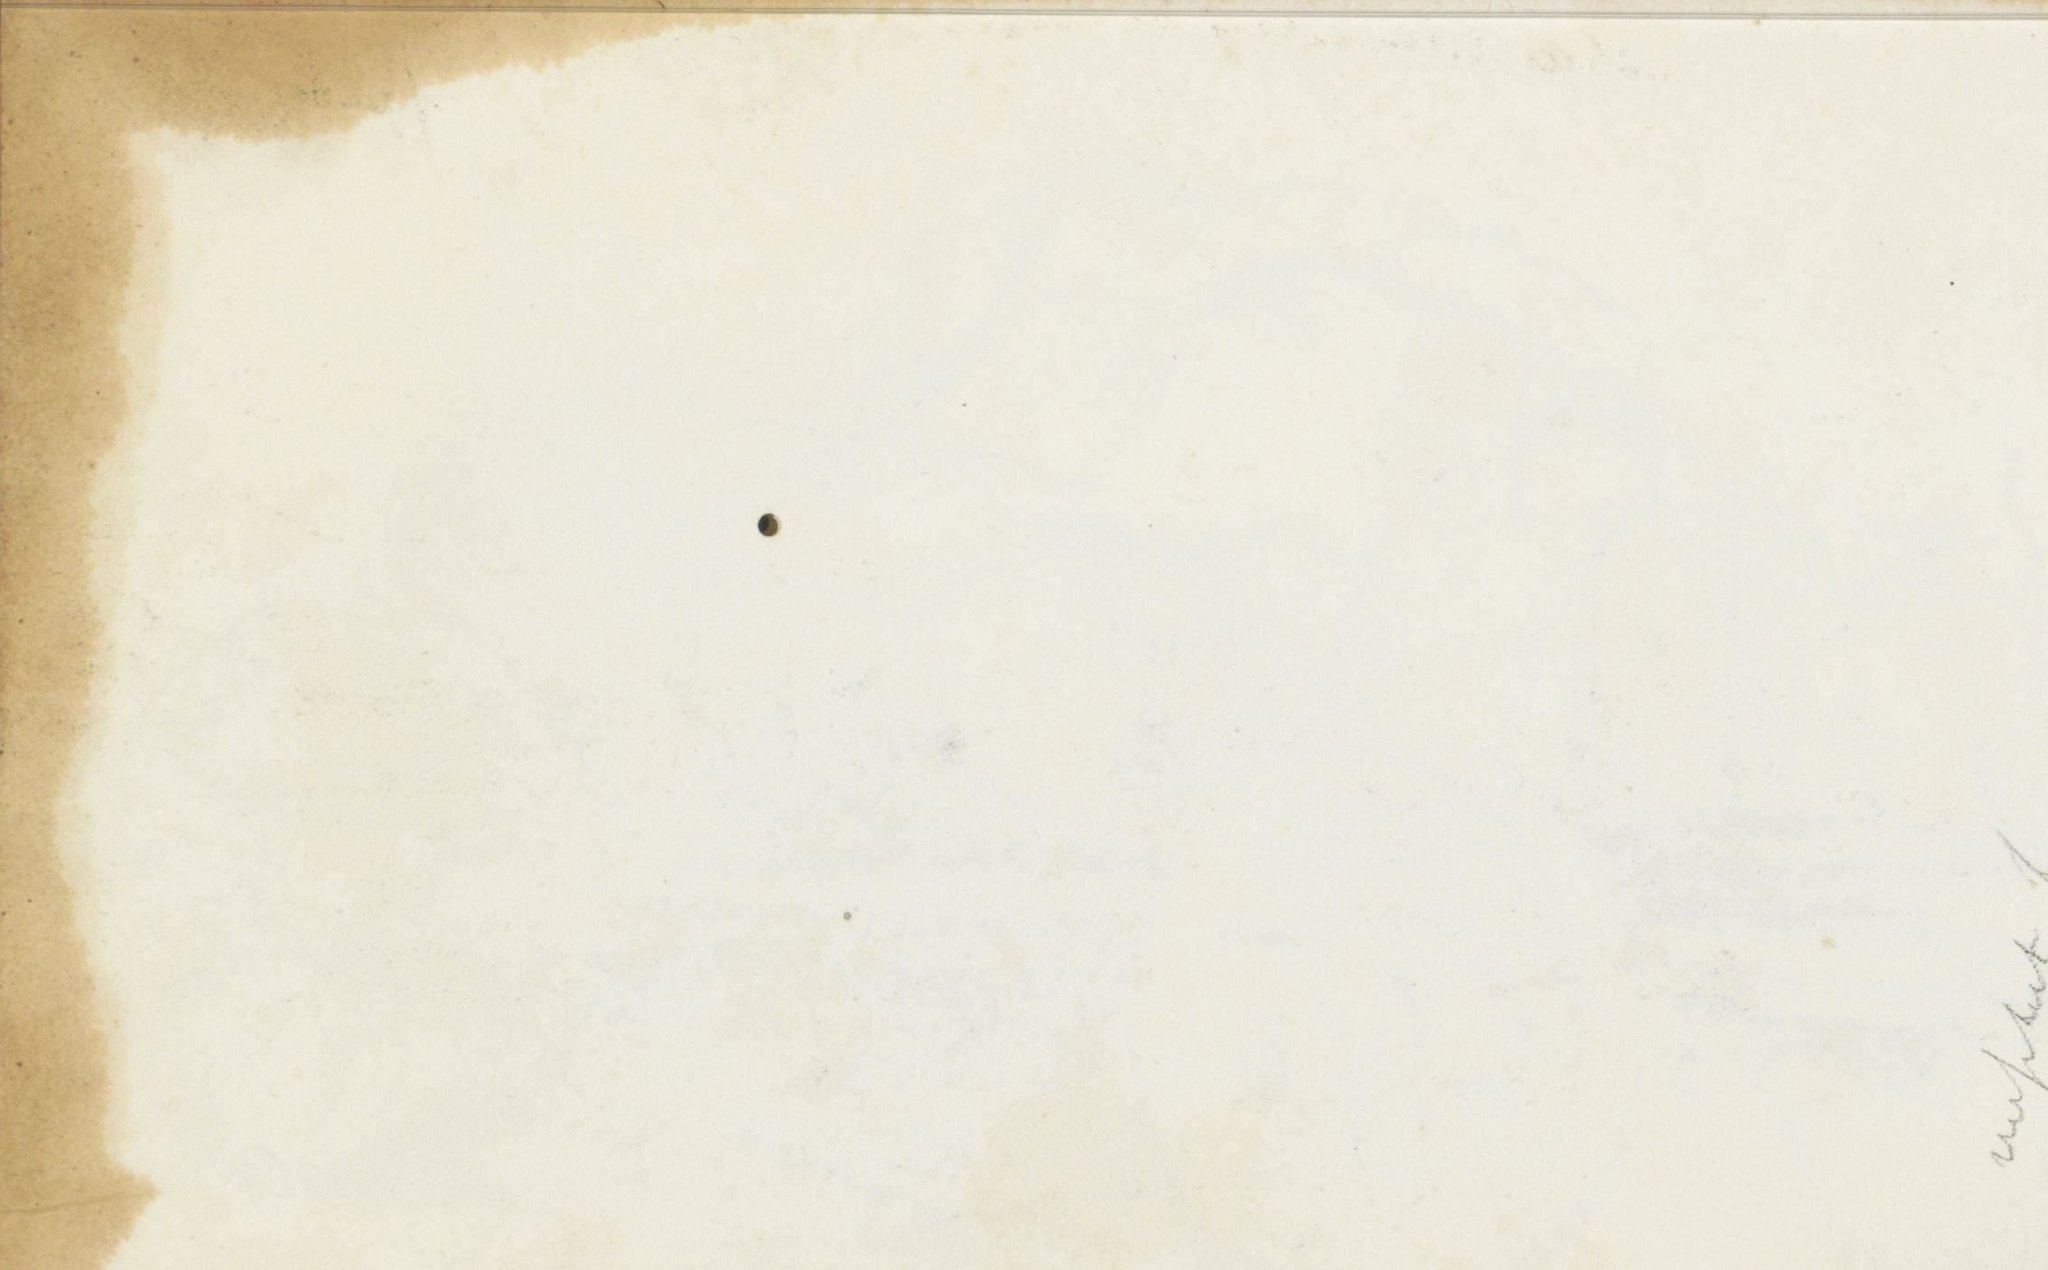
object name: sketchbook leaf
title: Kleurnotitie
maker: johannes tavenraat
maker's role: draughtsman, painter, print maker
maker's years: 1809-1881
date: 1840-1841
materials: paper, pencil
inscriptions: kleurnotitie, handgeschreven in potlood: de notitie verwijst naar de schets op blad 4 recto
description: Blad 3 verso uit een schetsboek met 41 bladen.